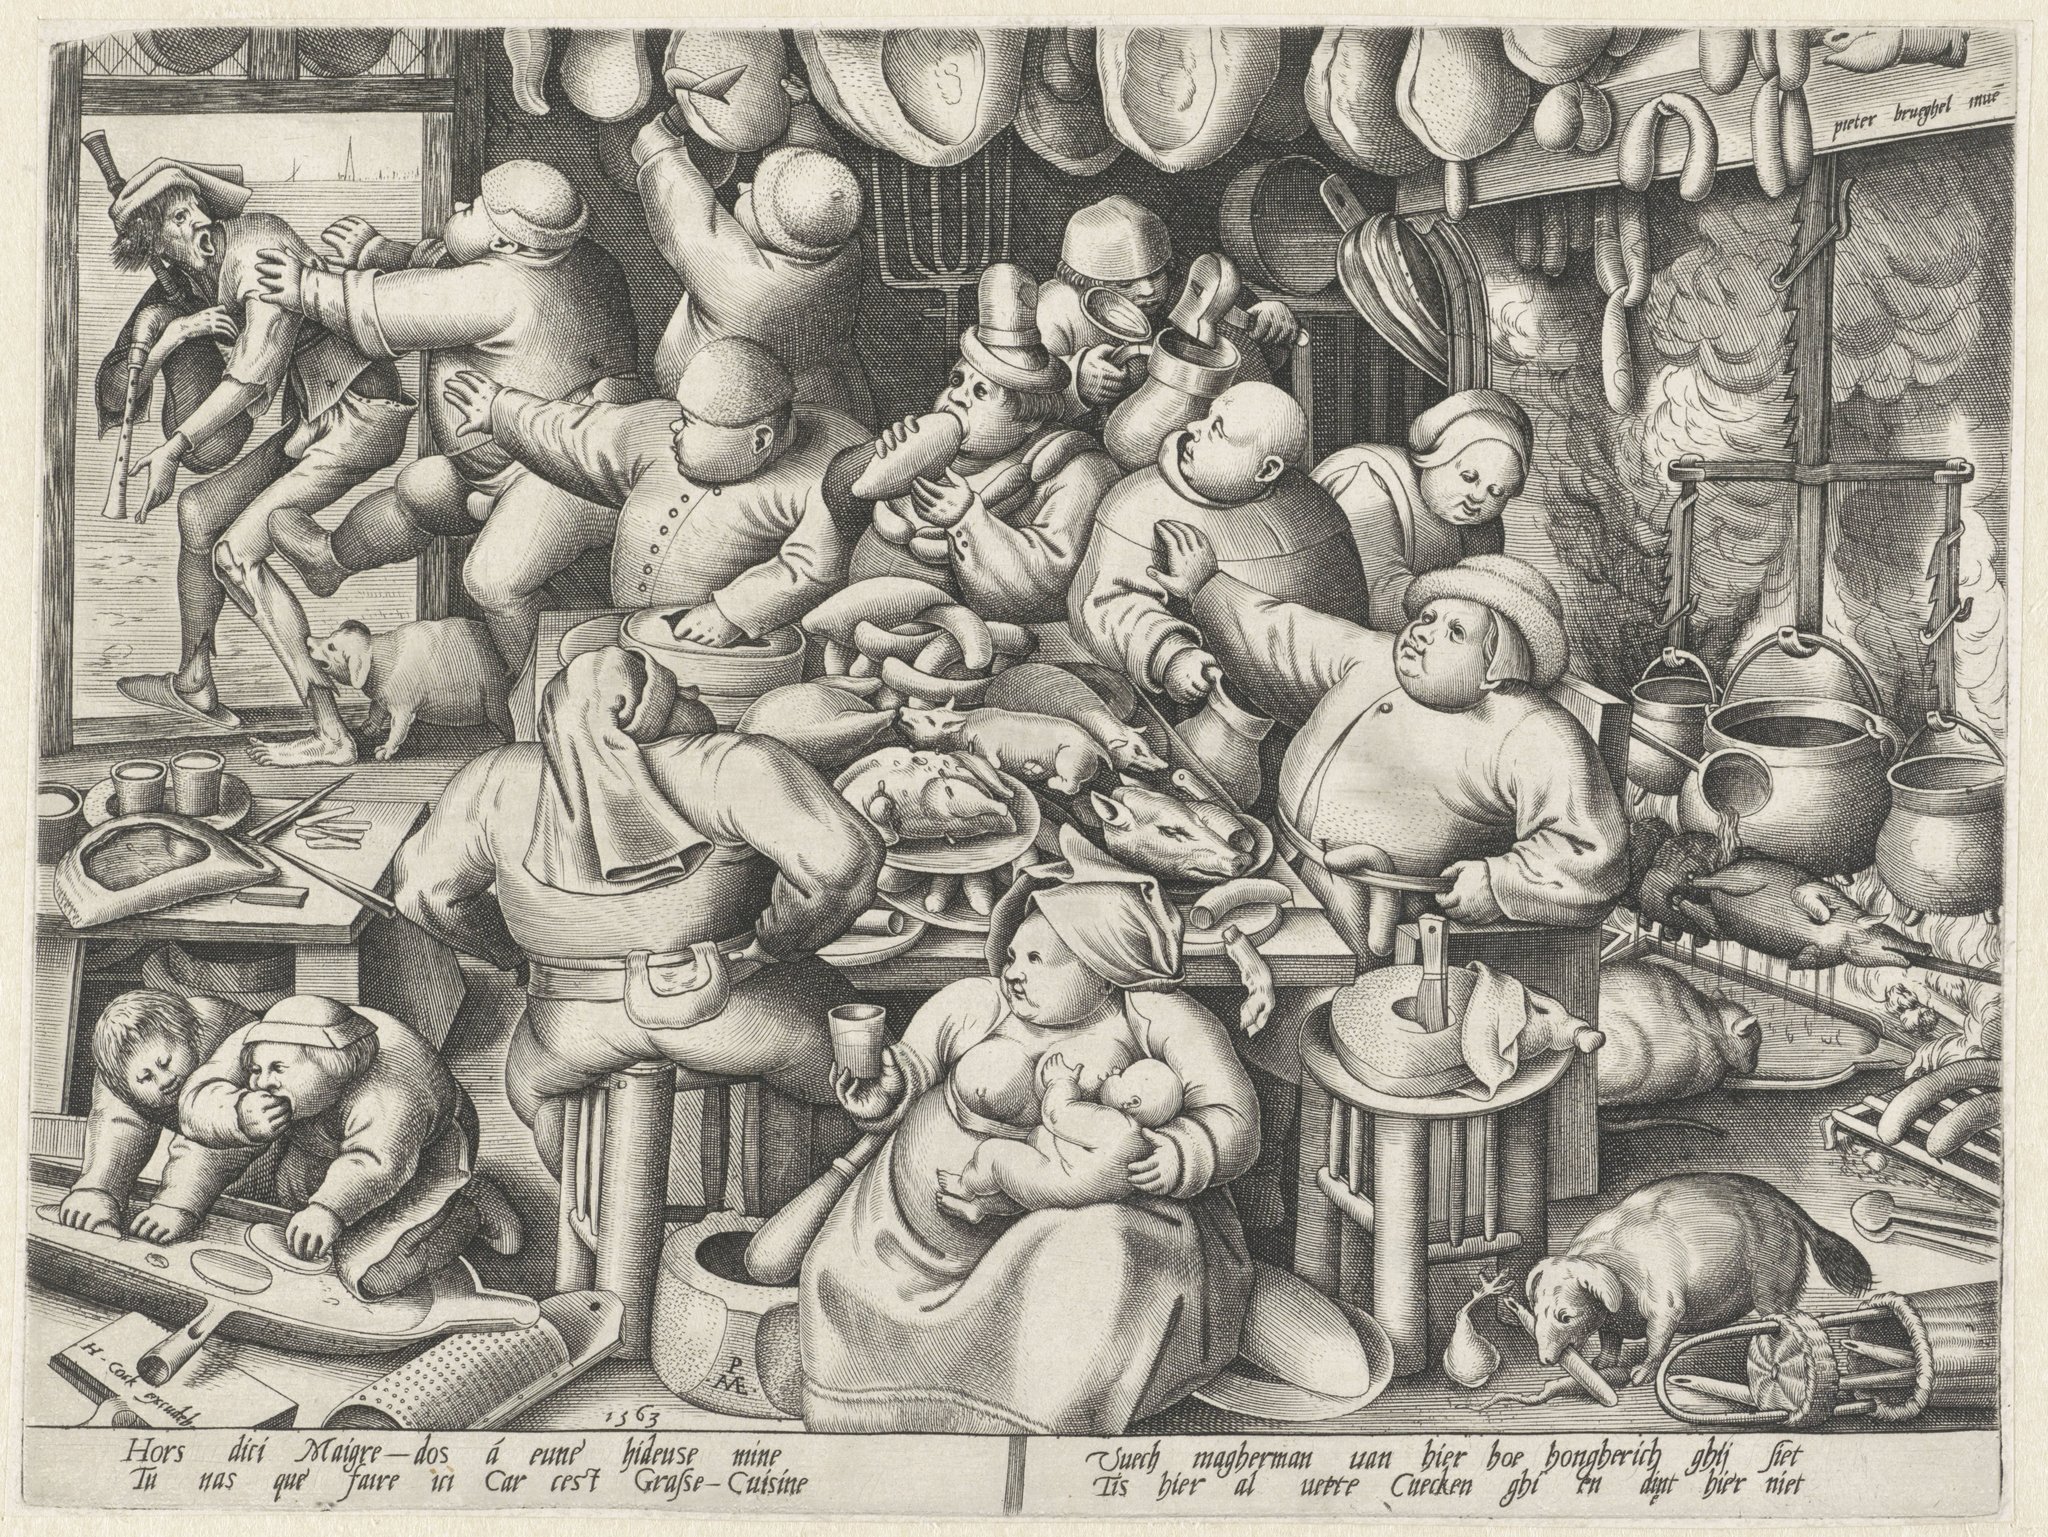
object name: print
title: Vette keuken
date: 1563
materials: paper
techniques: engraving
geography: antwerp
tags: fat (human type), bagpipe, musette, kitchen-interior, ham, beggar, rich kitchen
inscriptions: collector's mark: Lugt 2228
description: Keukeninterieur waarin een groep van dikke mensen zich aan allerlei eten en drinken te goed doet. Rechts wordt in de haard gekookt en gebraden. Op de voorgrond links twee met eten spelende kinderen en in het midden een drinkende vrouw die een kind de borst geeft, rechts een drinkende monnik of priester. Op de achtergrond wordt een armoedige magere man met doedelzak de deur uit gejaagd. Onder de voorstelling een tweeregelig vers in het Frans en in het Nederlands.